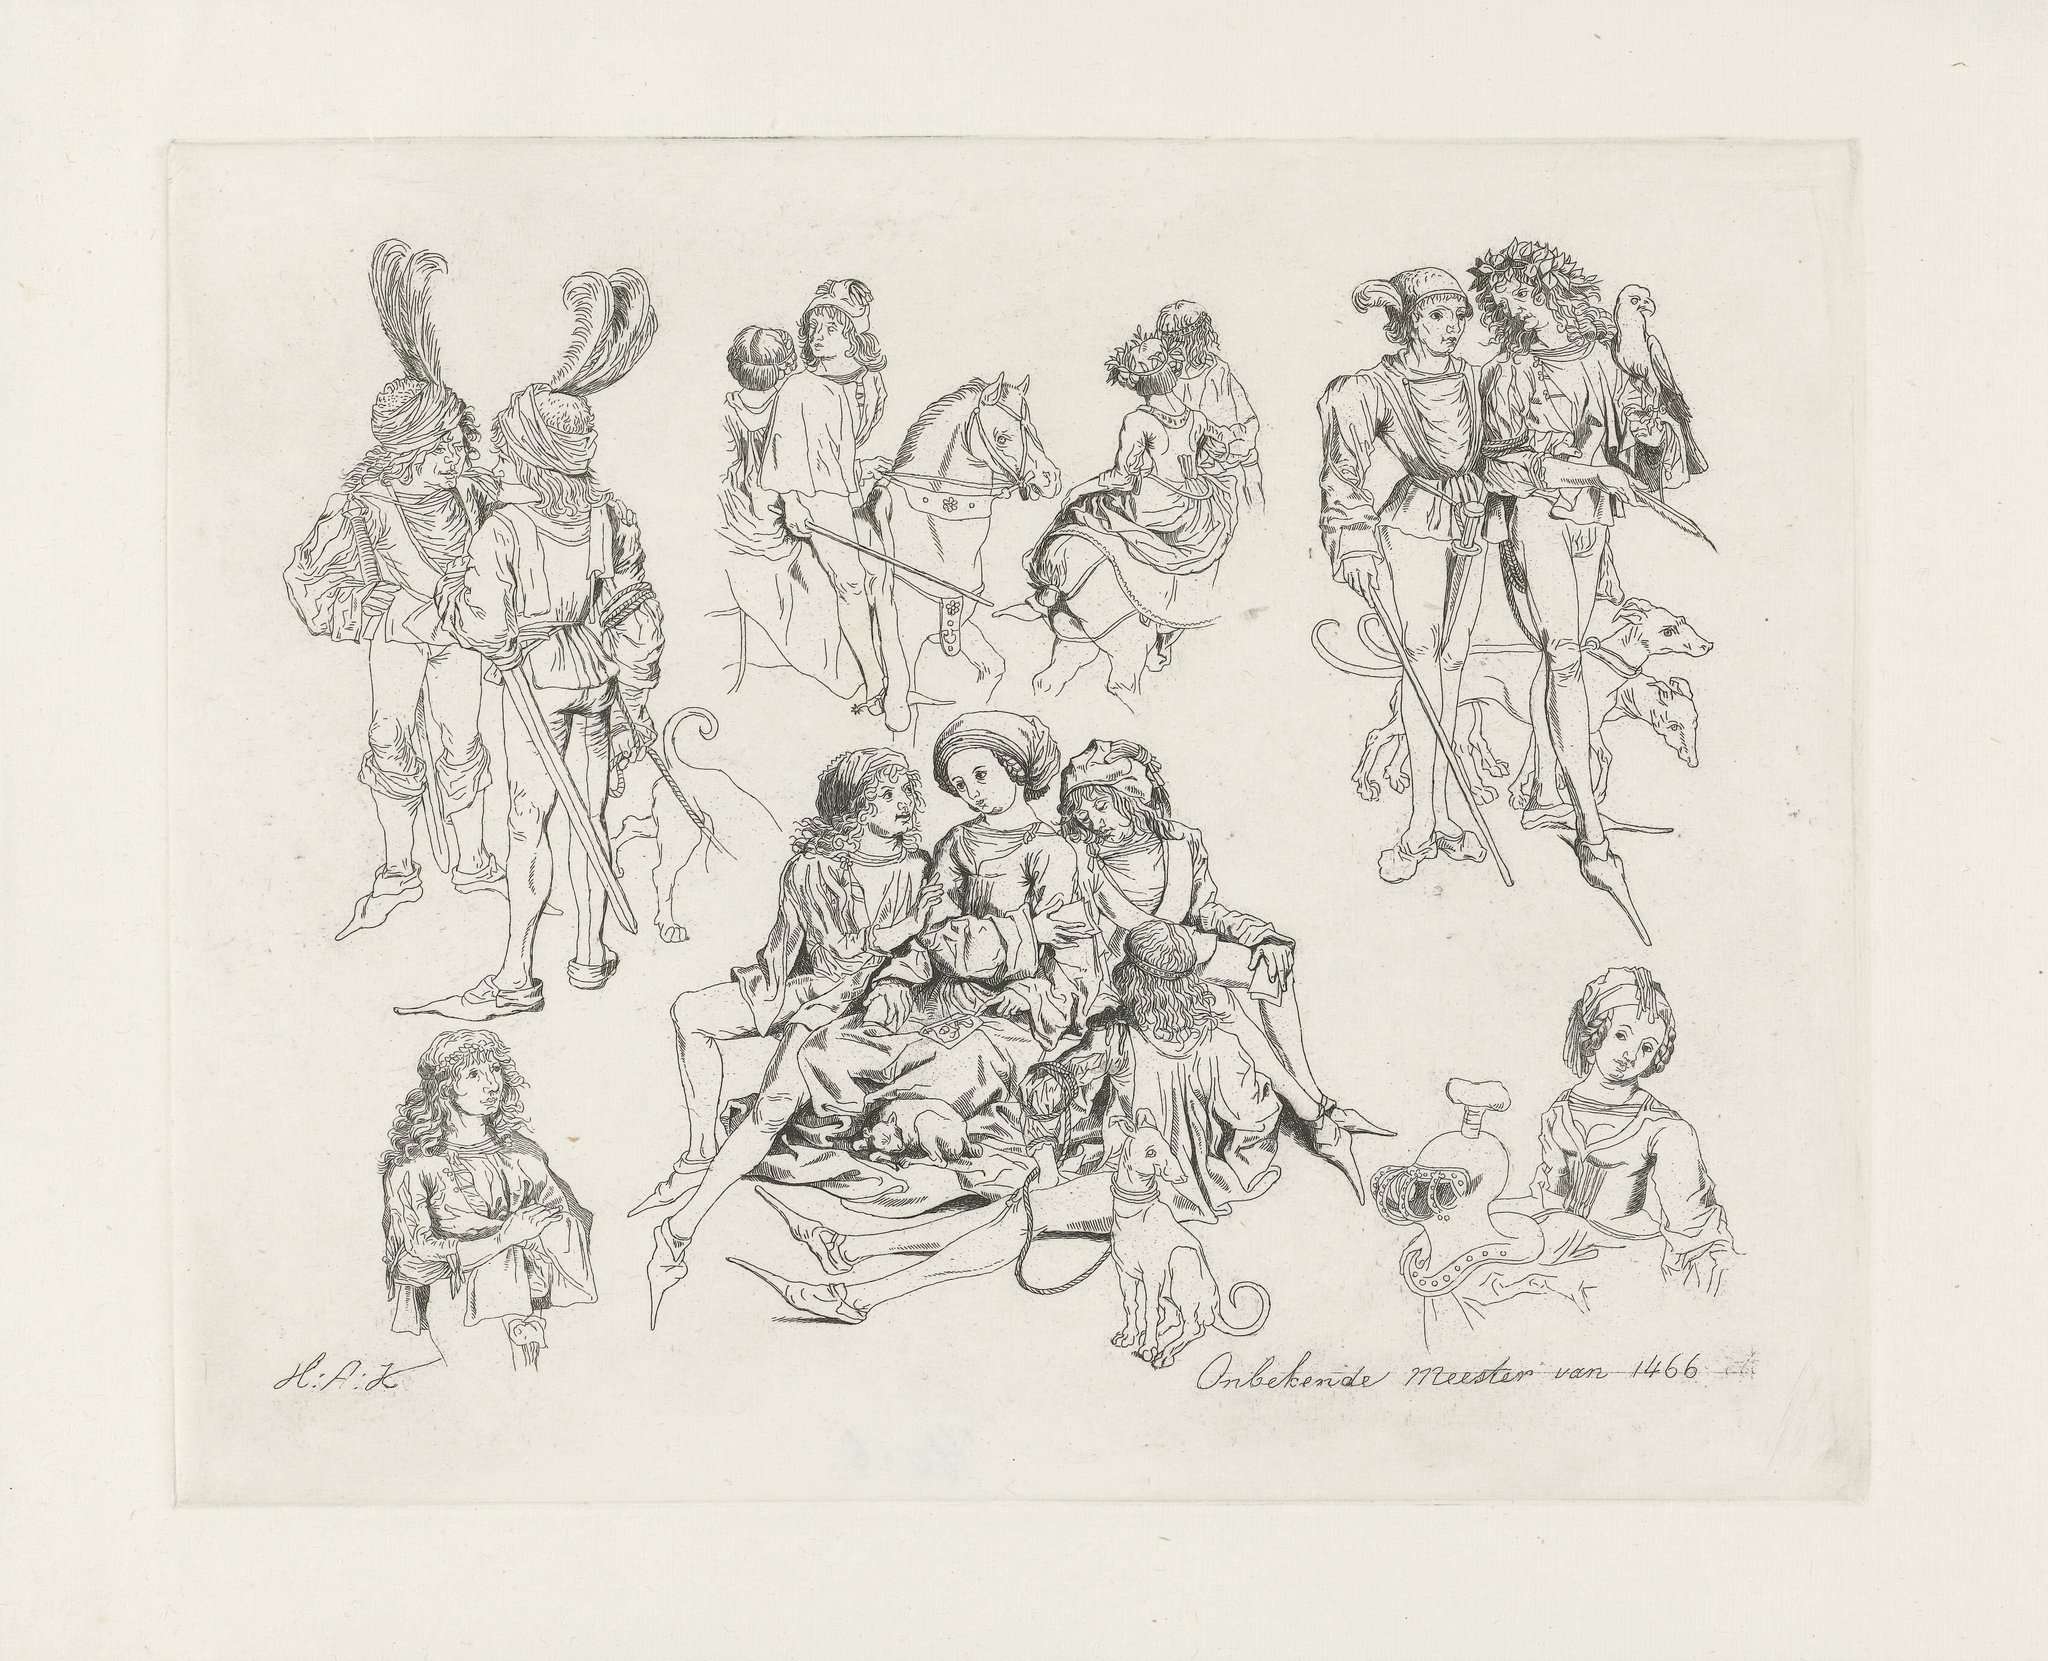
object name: print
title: Studieblad met figuren in Middeleeuwse kleding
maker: hendrik abraham klinkhamer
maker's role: draughtsman, painter, print maker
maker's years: 1810-1872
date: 1820-1872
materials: paper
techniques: etching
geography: amsterdam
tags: predatory birds: falcon, adult woman, adult man, horse, dog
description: Studieblad met diverse figuren in Middeleeuwse kleding. Links twee mannen met een tulband met veren op het hoofd. Rechtsboven twee mannen waarvan er één een valk op zijn arm heeft, achter hen twee honden. In het midden bekijken een jonge vrouw en drie mannen verschillende afbeeldingen. Boven deze groep twee paren te paard.